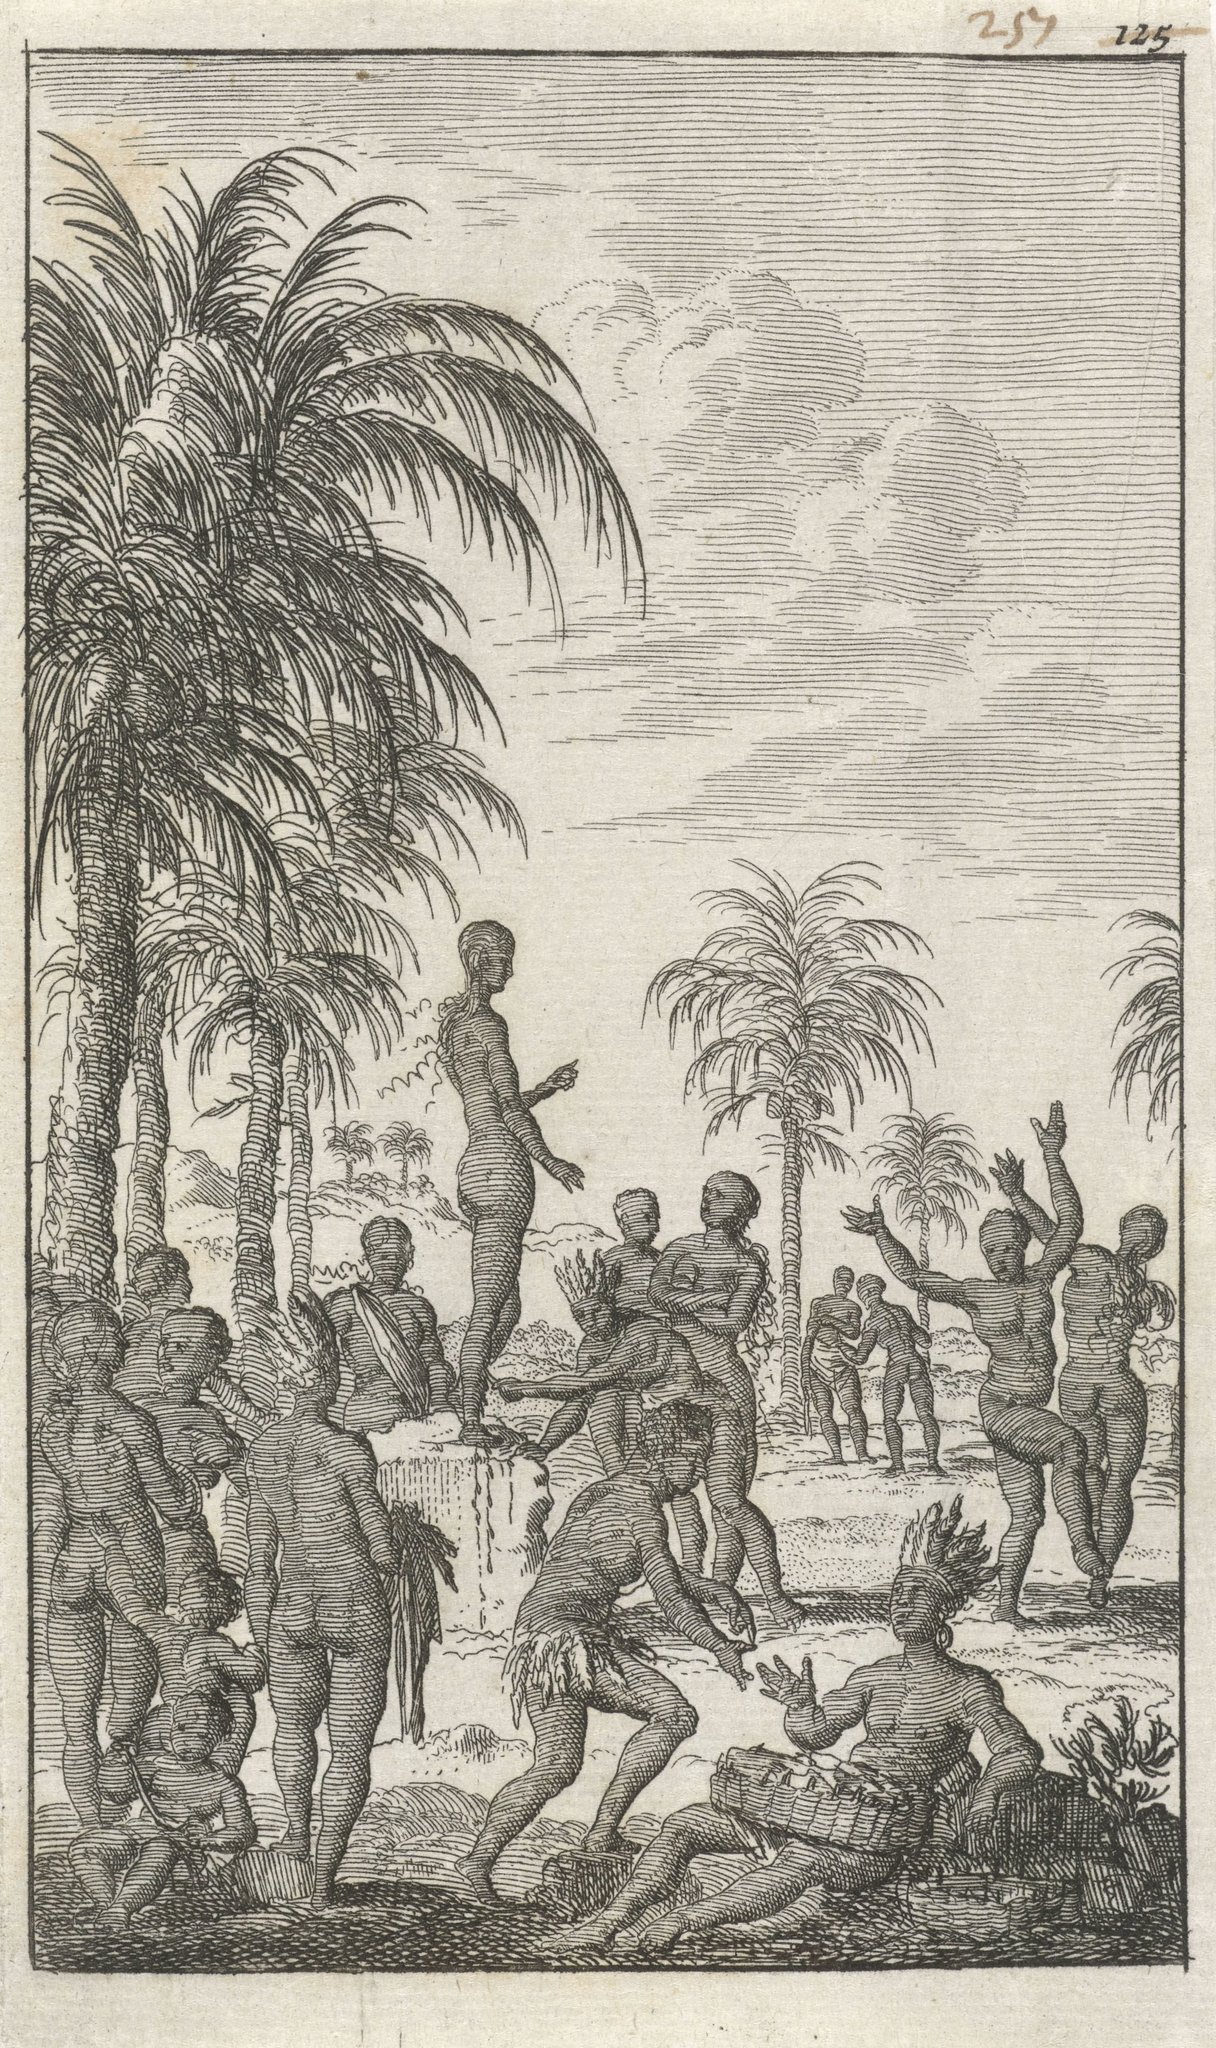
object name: print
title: Braziliaanse plechtigheid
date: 1681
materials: paper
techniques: etching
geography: amsterdam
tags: ritual practices ~ american indian religions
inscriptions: number: ‘251’, collector's mark: Lugt 2228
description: Illustratie opgenomen in: Neyn, Pieter de. Lust-hof der huwelyken, behelsende verscheyde seldsame ceremonien (...) by verscheyde natien. Amsterdam: Jan Bouman, 1681.